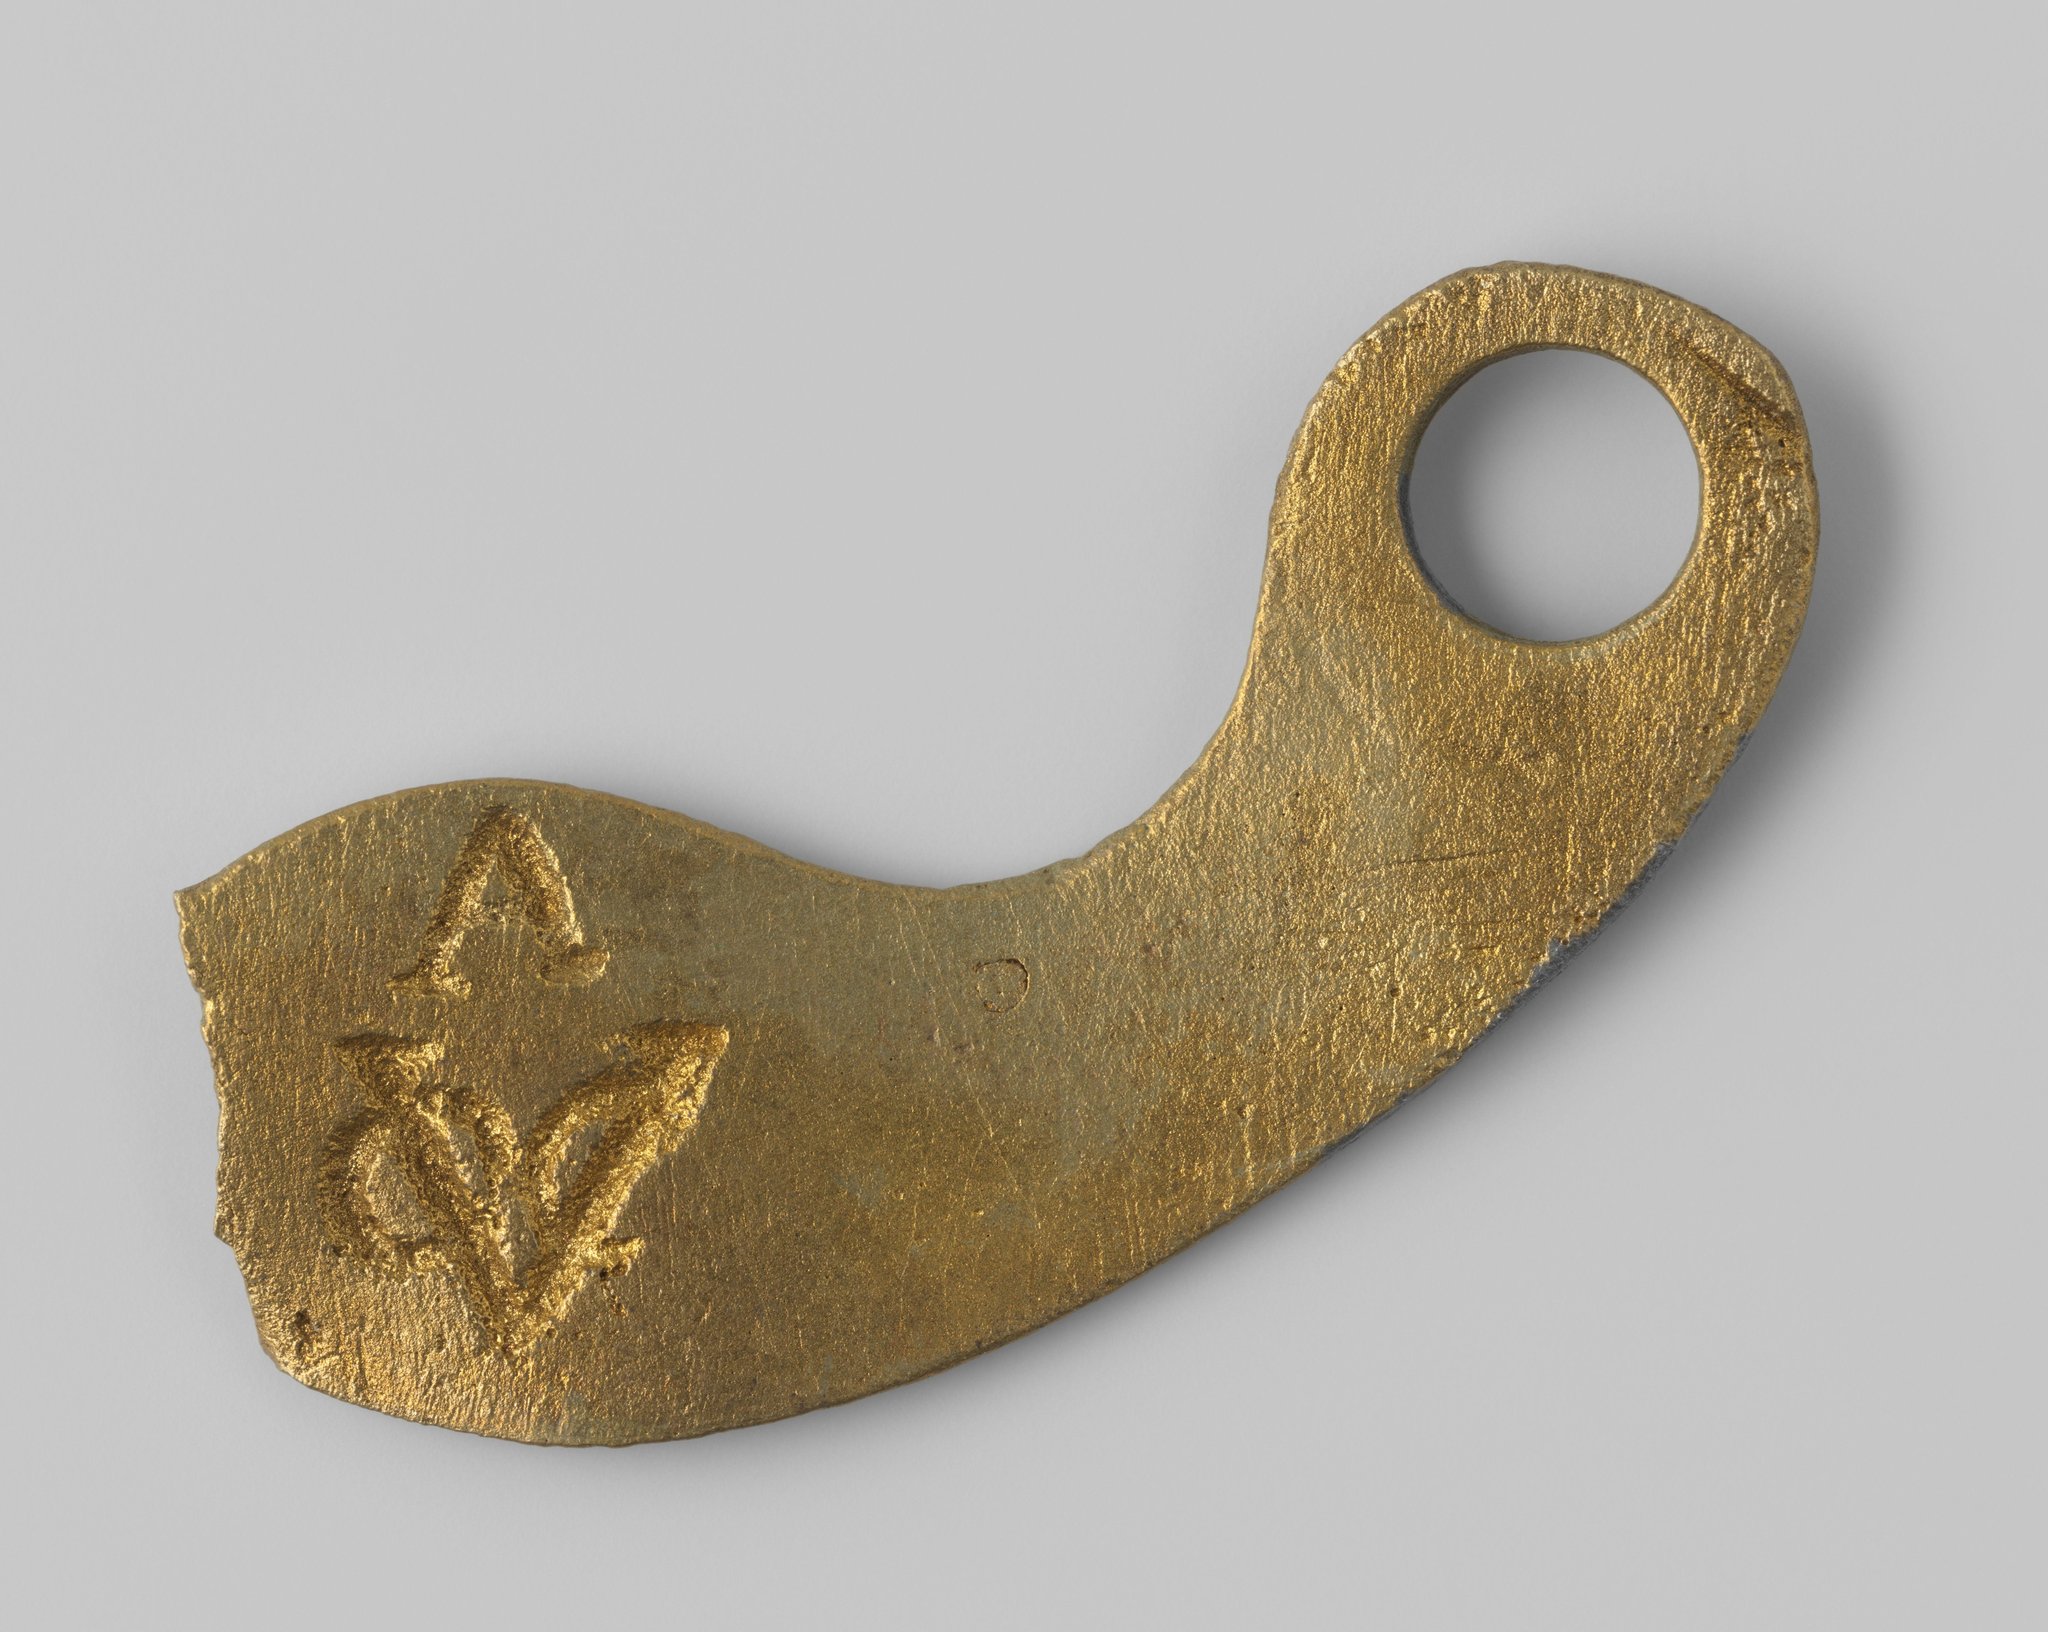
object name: schroefplaat, schroefblik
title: Fragment schroefplaat van een musket uit het wrak van de Oost-Indiëvaarder Hollandia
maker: Anonymous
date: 1700-1743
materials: copper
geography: netherlands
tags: verenigde oostindische compagnie, hollandia (schip), annet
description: Fragm, right wing id. NG 1978-74H986 or NG 1980-27H3069, side plate.